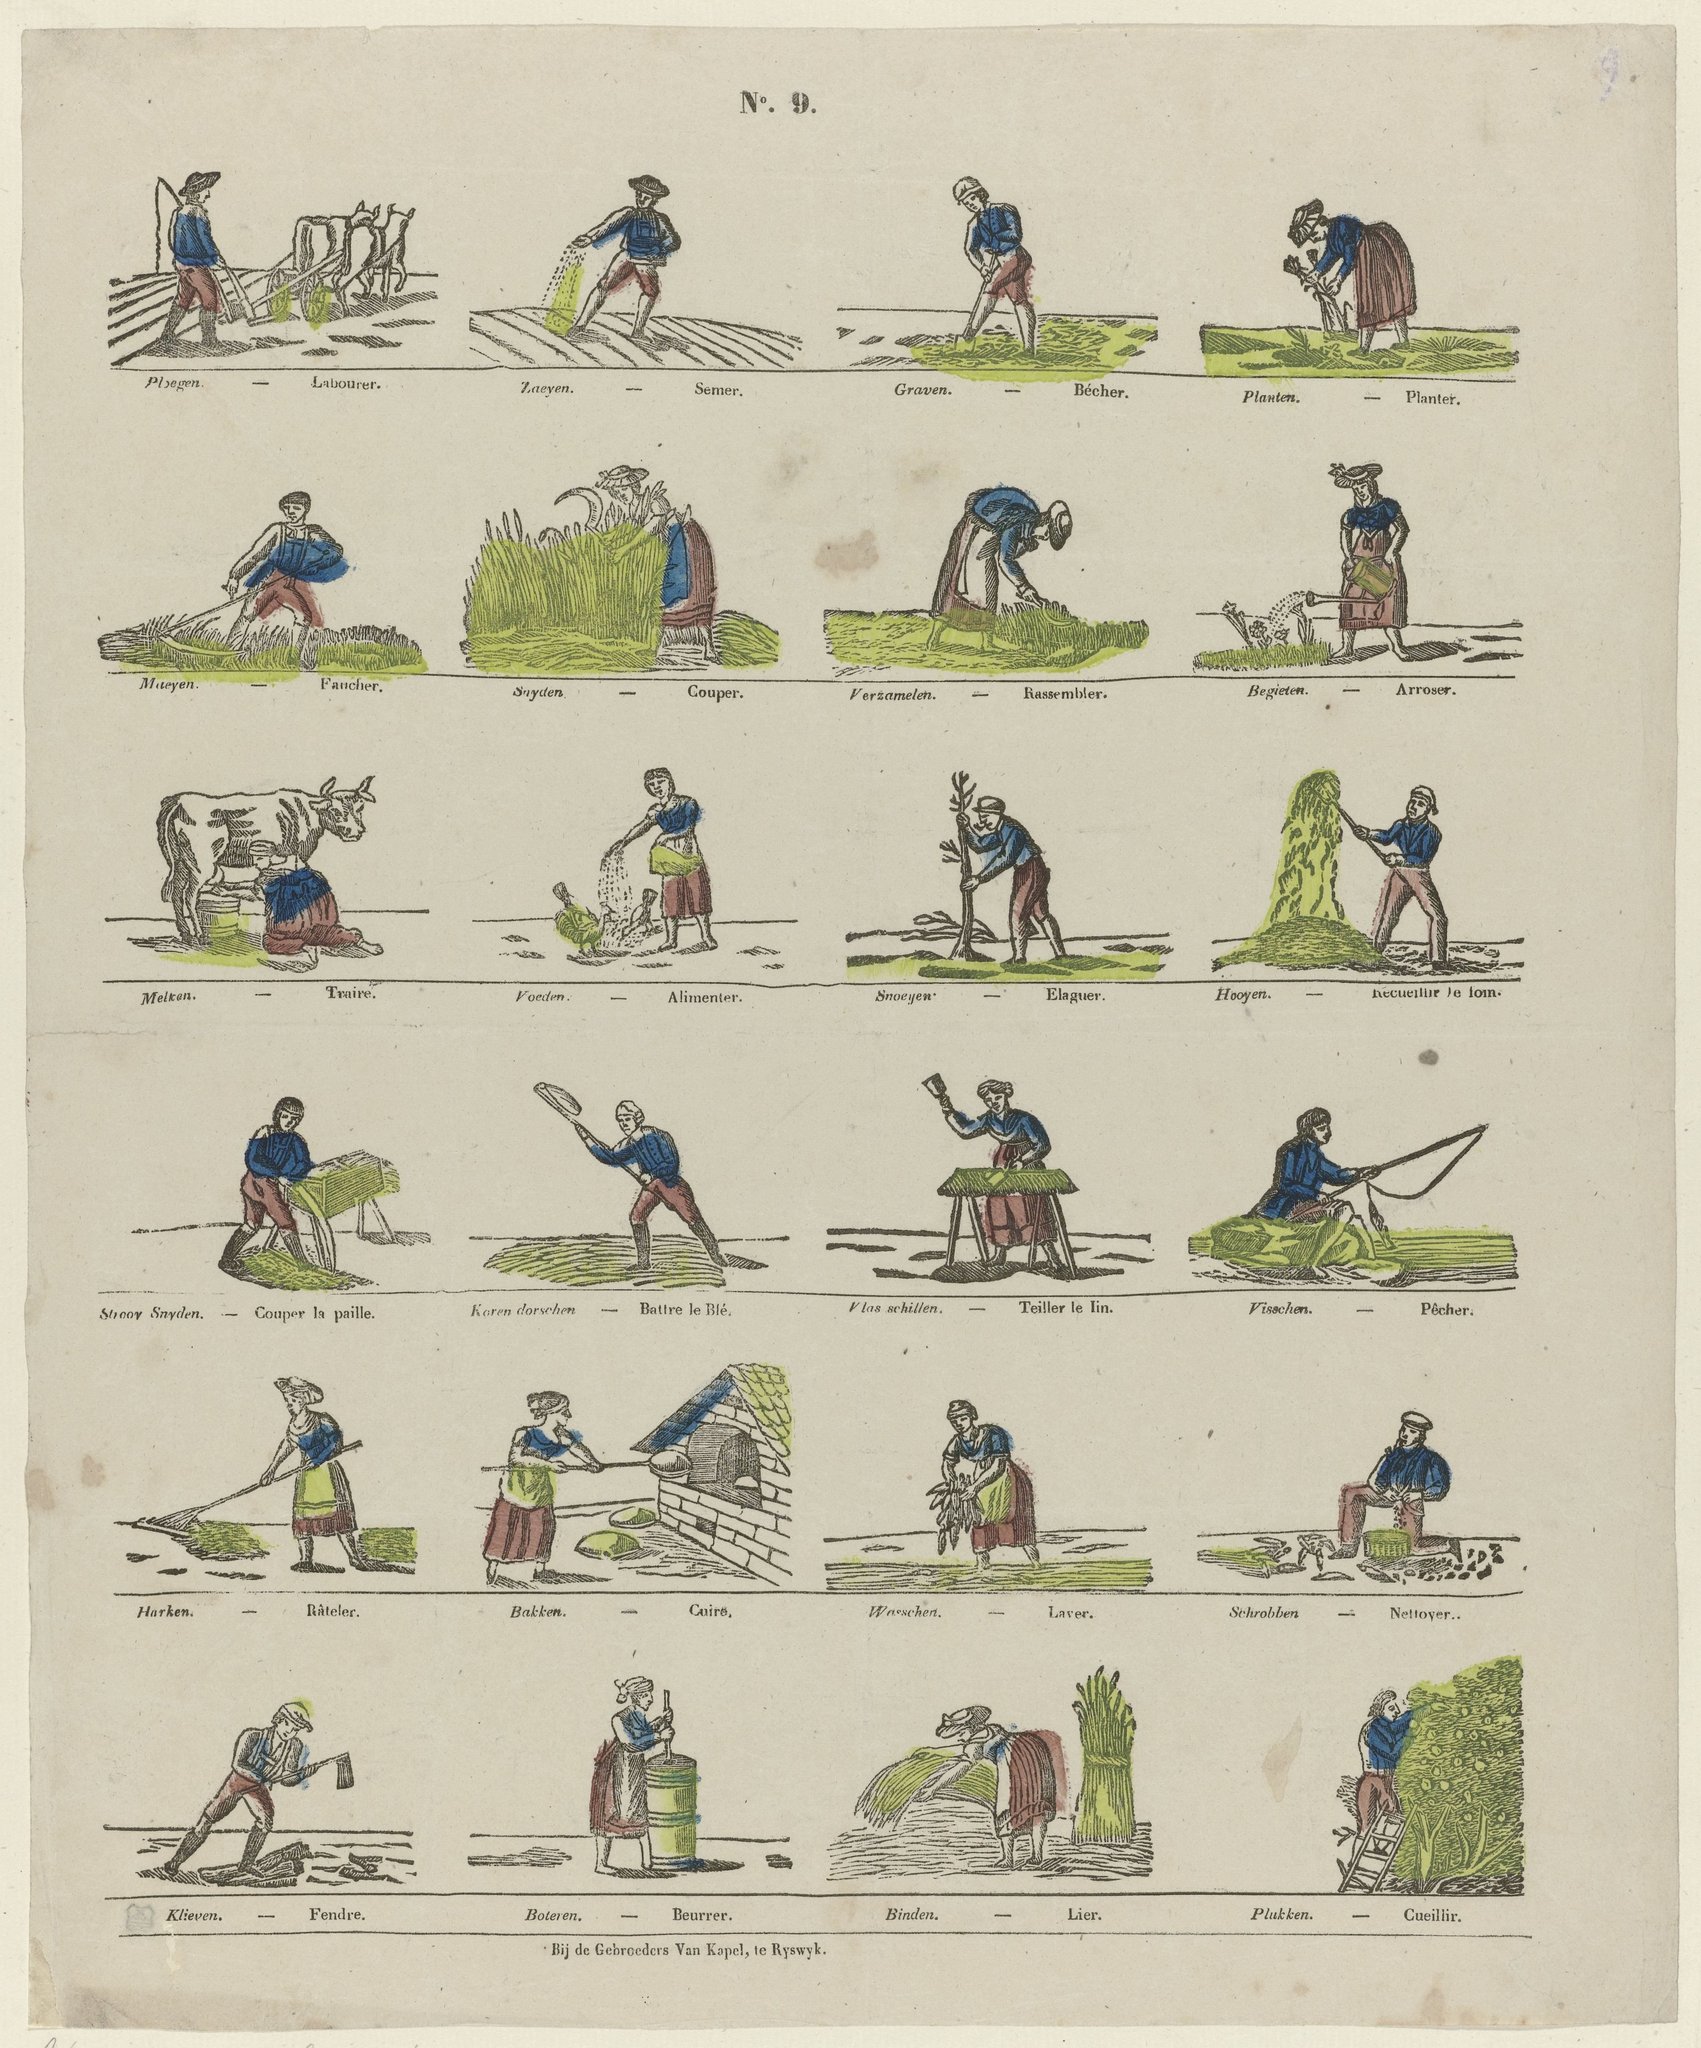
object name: print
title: Landleven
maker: Anonymous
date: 1833-1856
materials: paper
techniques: colour, letterpress printing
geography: turnhout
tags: farmers, agriculture, ploughing, milking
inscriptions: collector's mark: Lugt 2760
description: Blad met 24 voorstellingen van werkzaamheden op het platteland, zoals gewassen zaaien, planten water geven, koeien melken en broden bakken. Onder elke afbeelding een onderschrift in het Nederlands en in het Frans. Genummerd midden boven: No. 9.